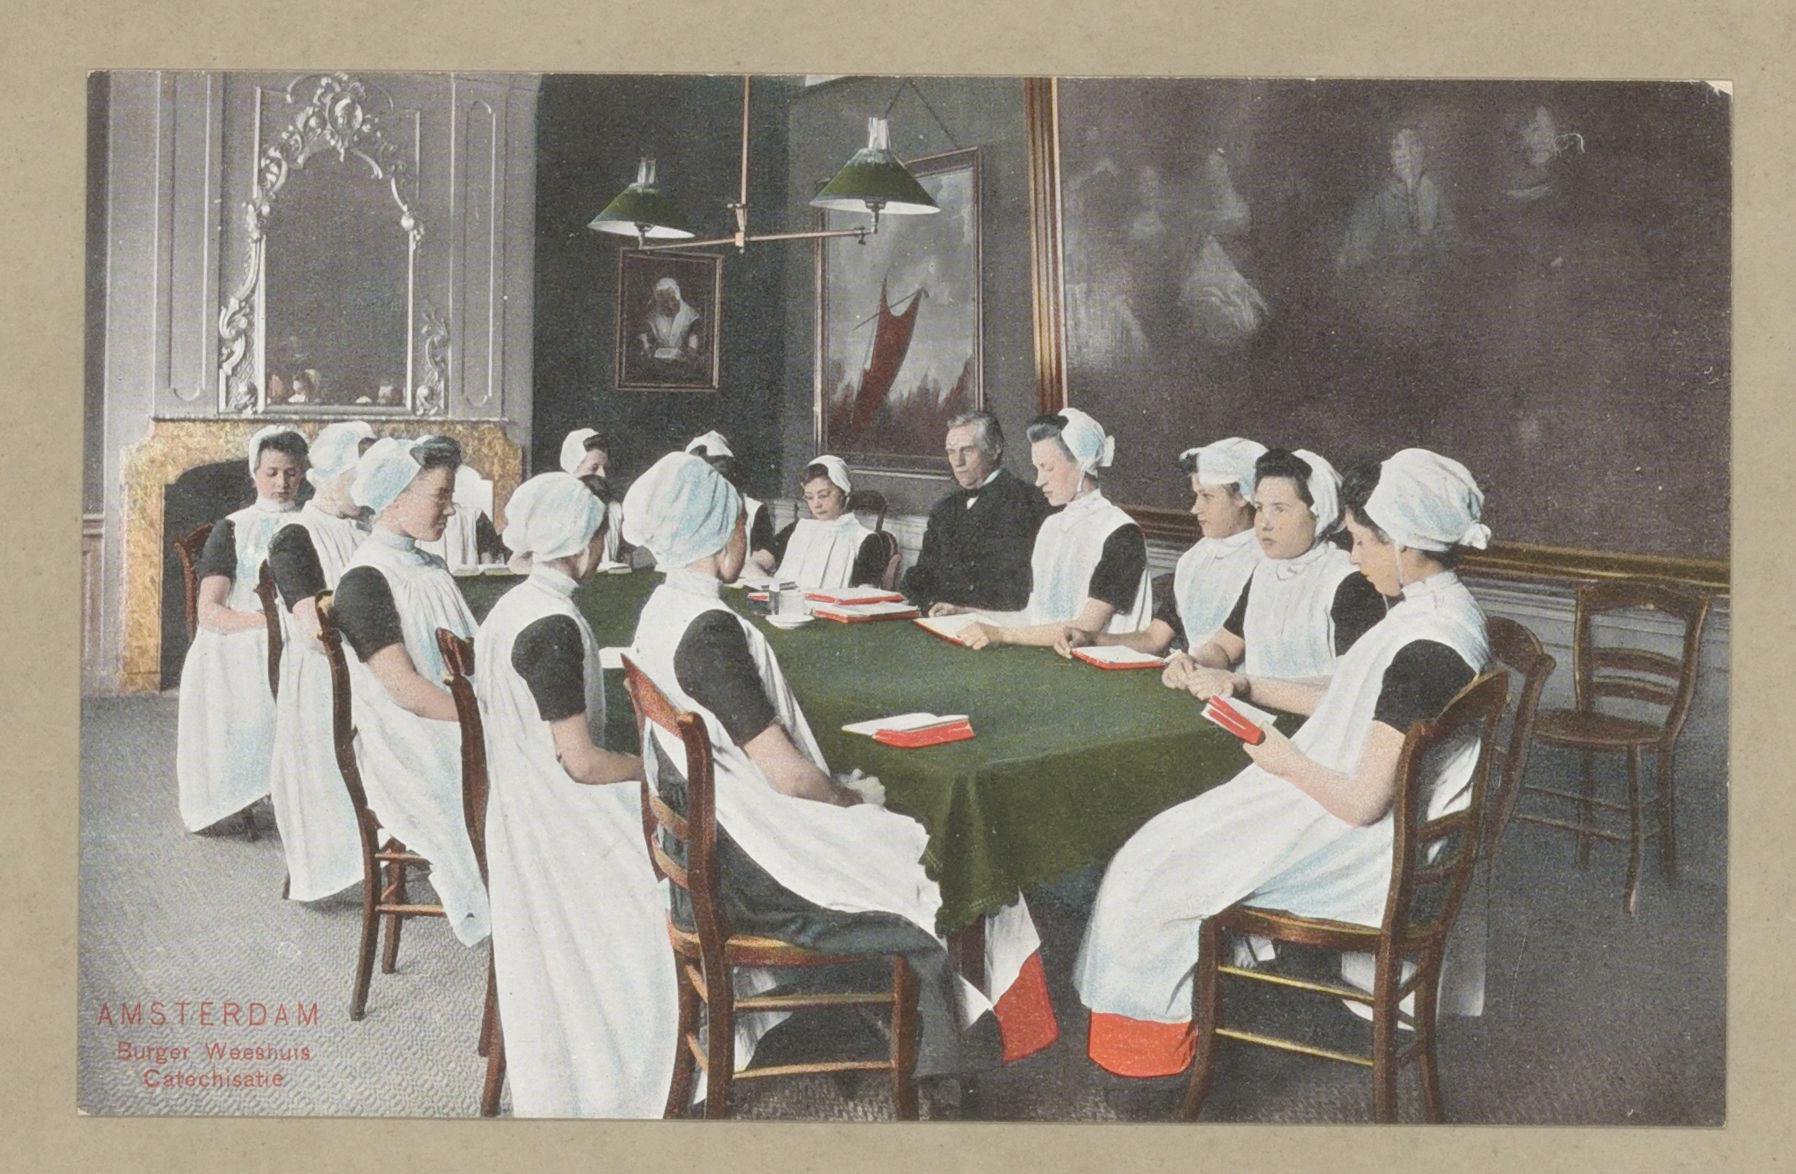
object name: photomechanical print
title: Catechisatie in het Burgerweeshuis te Amsterdam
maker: Anonymous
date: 1890-1920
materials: cardboard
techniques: four-color autotype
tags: orphanage, orphans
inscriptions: collector's mark: Lugt 1641b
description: Onderwerpsrubriek binnen de Atlas Amsterdam: Armwezen en liefdadige instellingen: I. Stadsinrichtingen: Burgerweeshuis.